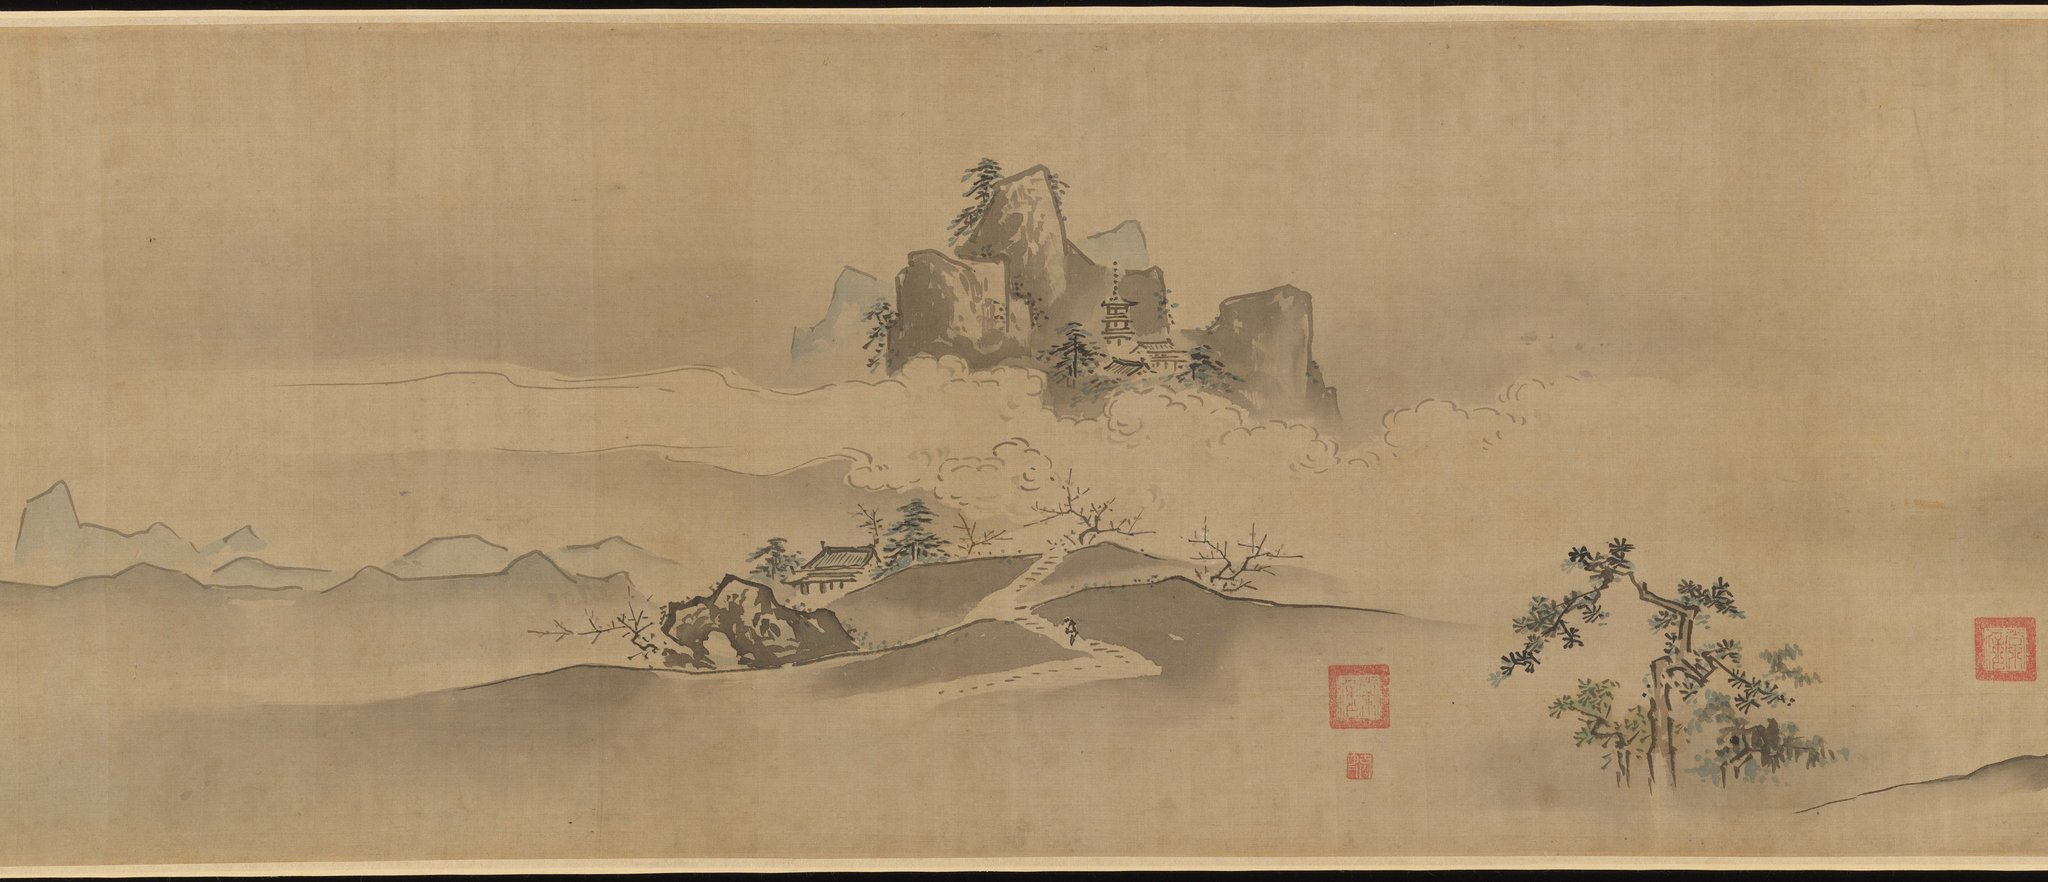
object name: handscroll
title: Eight Views of the Xiao and Xiang Rivers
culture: japanese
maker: kano tsunenobu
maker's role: artist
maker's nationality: japanese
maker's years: 1636-1713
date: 1667-1733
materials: ink, silk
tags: mountains,landscapes